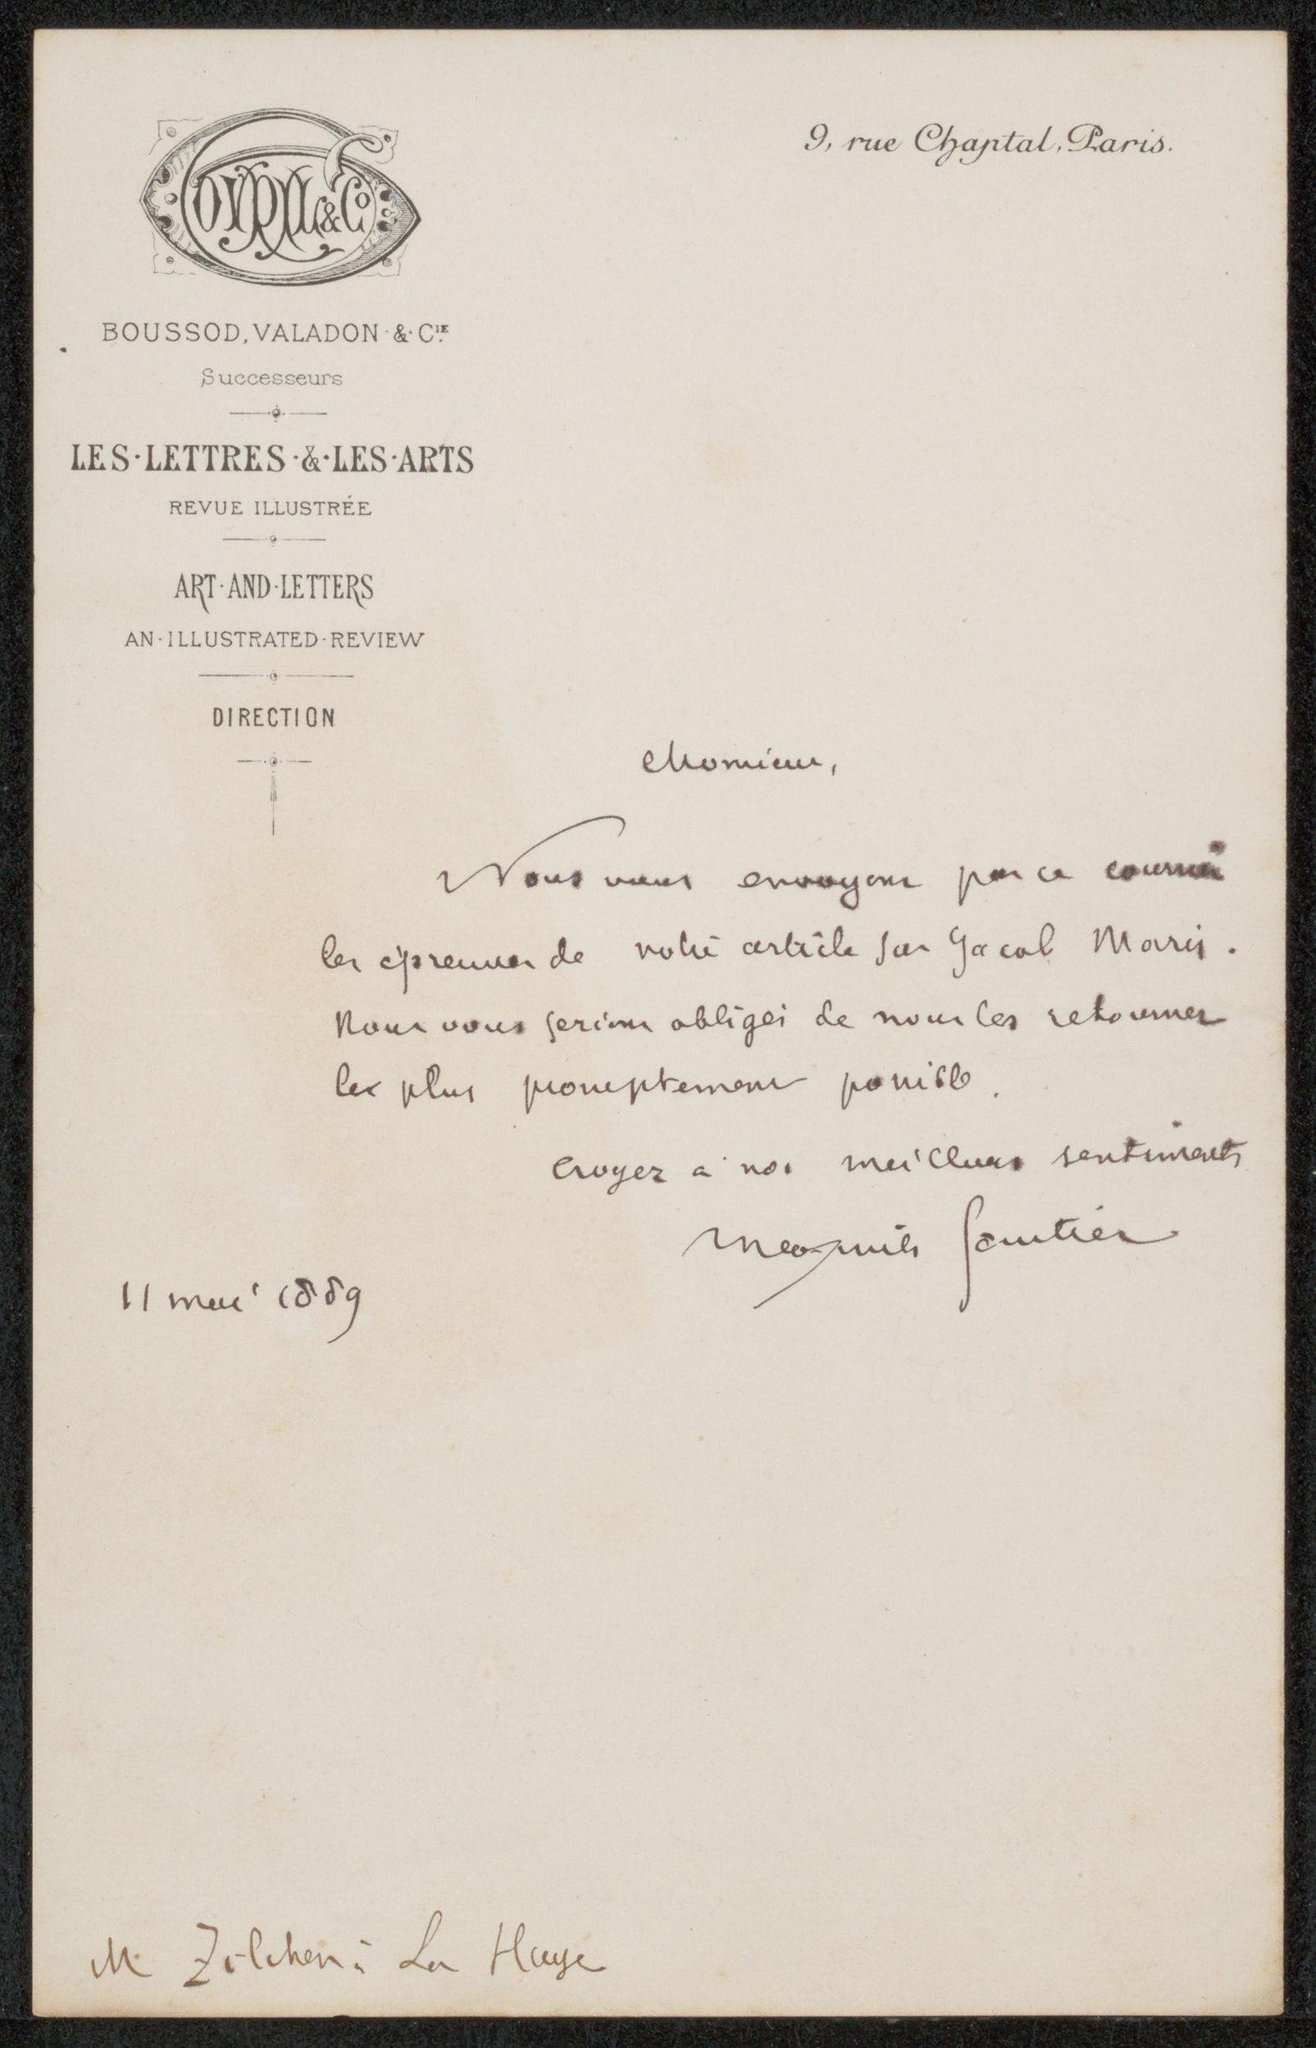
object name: letter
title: Brief aan Philip Zilcken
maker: théophile gautier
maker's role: letterkundige, vertaler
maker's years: 1836-1904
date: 1889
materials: ink, paper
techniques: pen, printing, writing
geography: paris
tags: the hague, london, painter, print maker, draughtsman, matthijs maris, philip zilcken, literature ~ arts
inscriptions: collector's mark: ‘RPK’